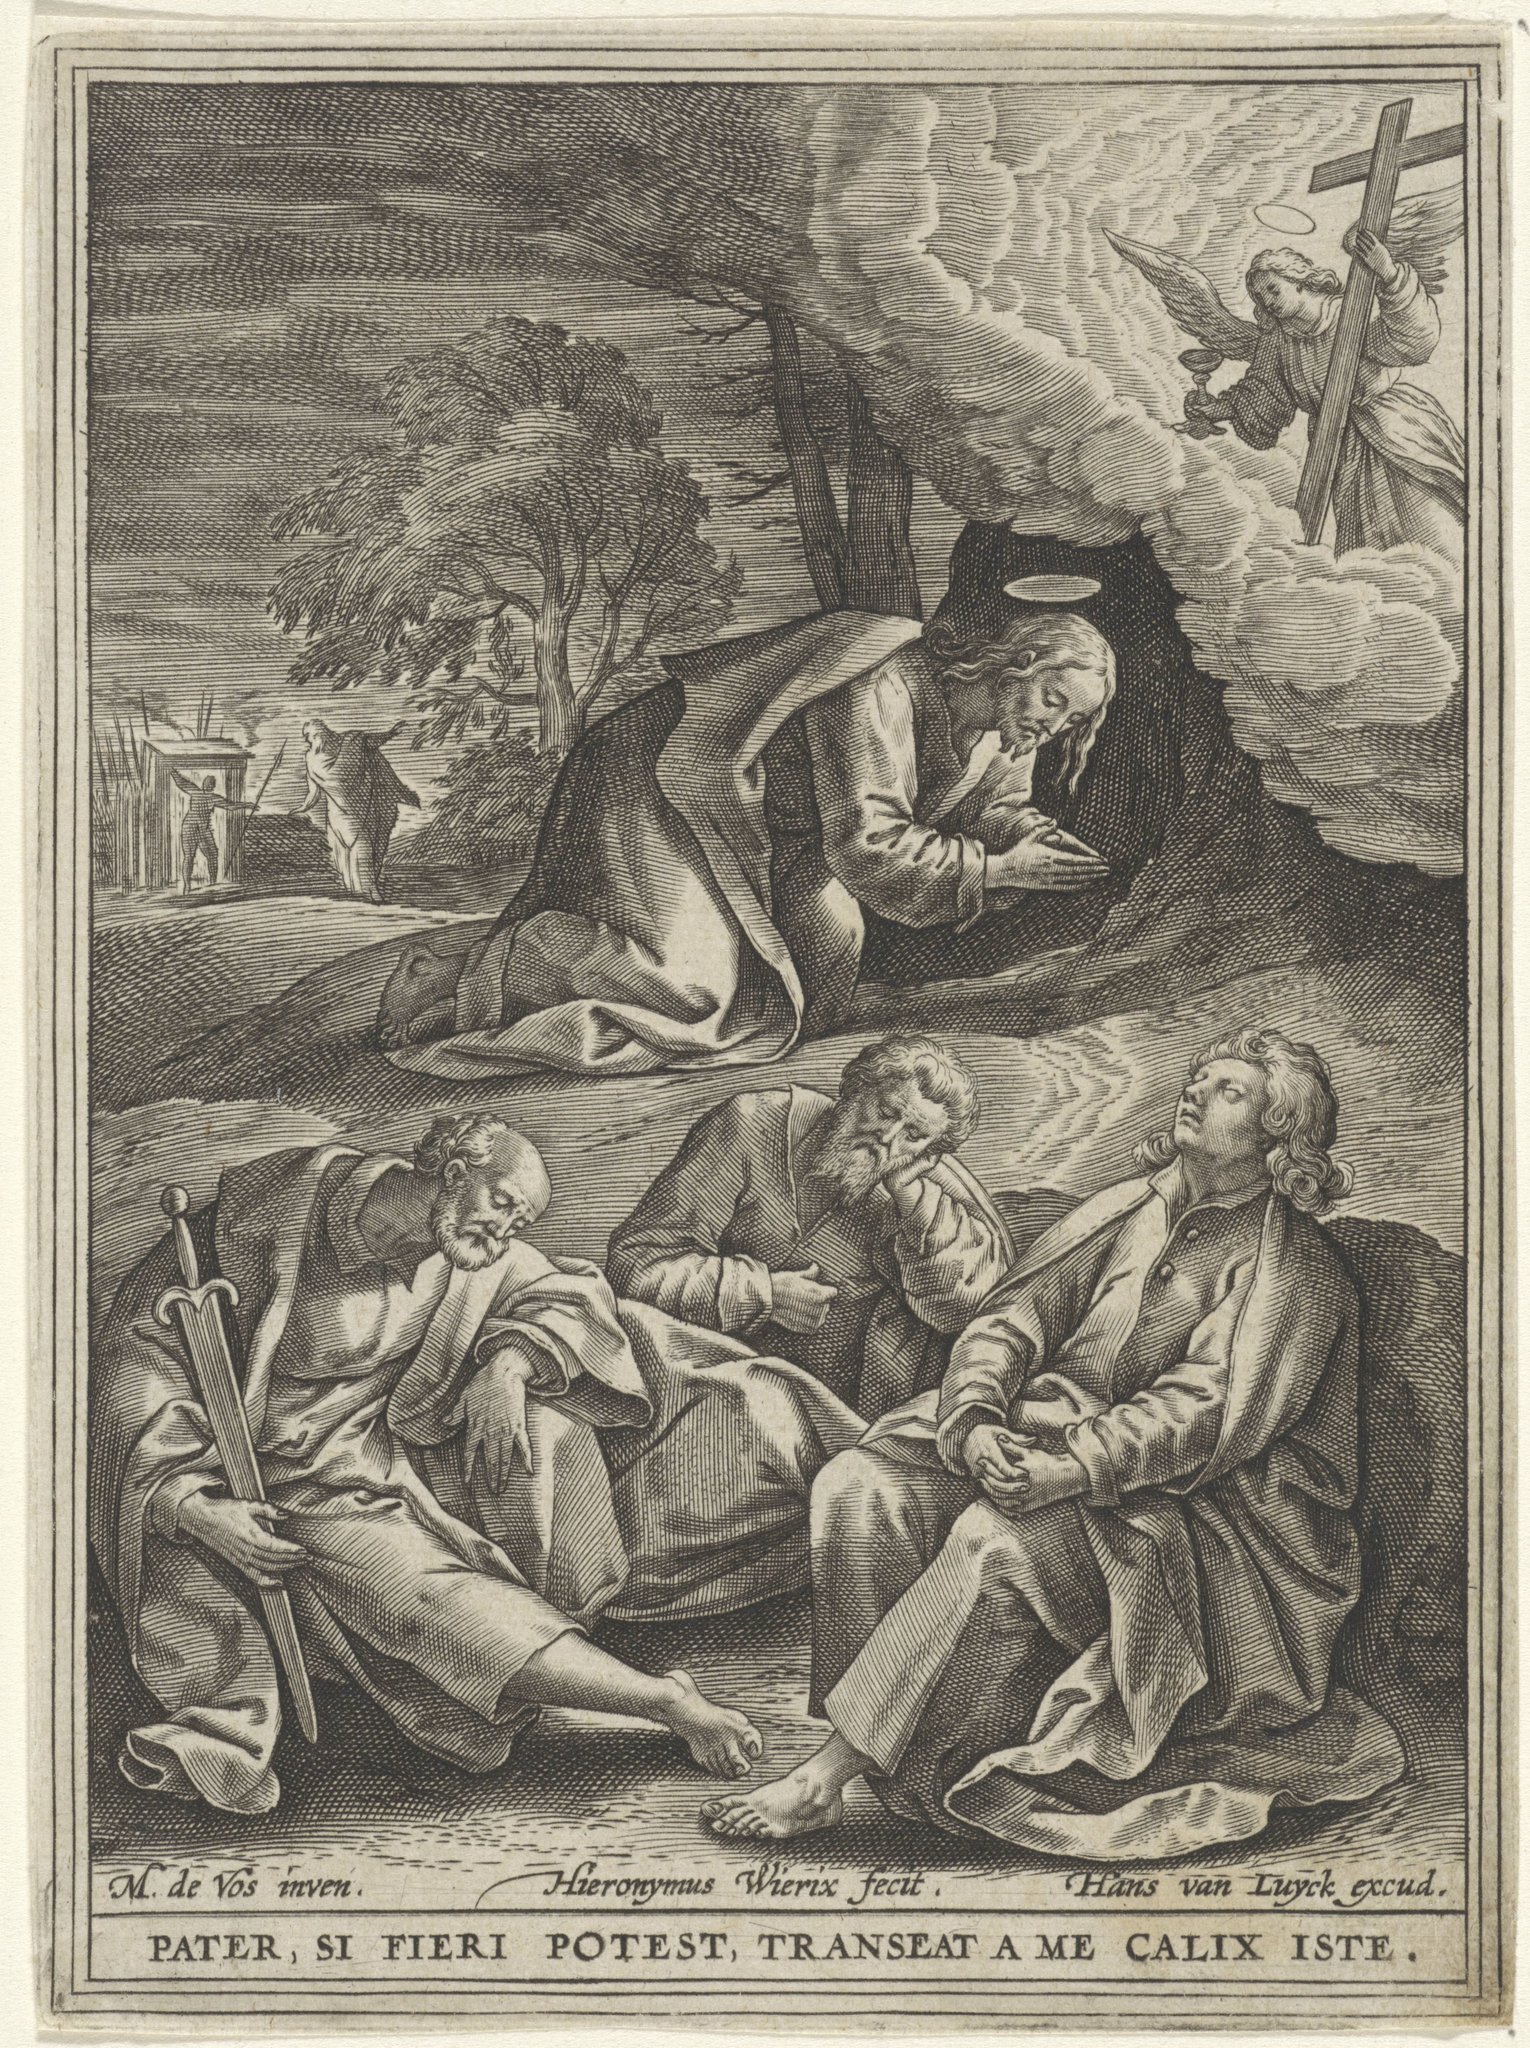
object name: print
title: Passie van Christus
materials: paper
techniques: engraving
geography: antwerp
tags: christ's prayer in the garden of gethsemane during the night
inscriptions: collector's mark: Lugt 2228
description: Christus bidt in de hof van Getsemane. Uit de hemel verschijnt een engel met een kelk. Op de voorgrond slapen Petrus, Johannes en Jacobus. Op de achtergrond leidt Judas soldaten door de poort naar binnen. In de marge een onderschrift in het Latijn dat verwijst naar de voorstelling.